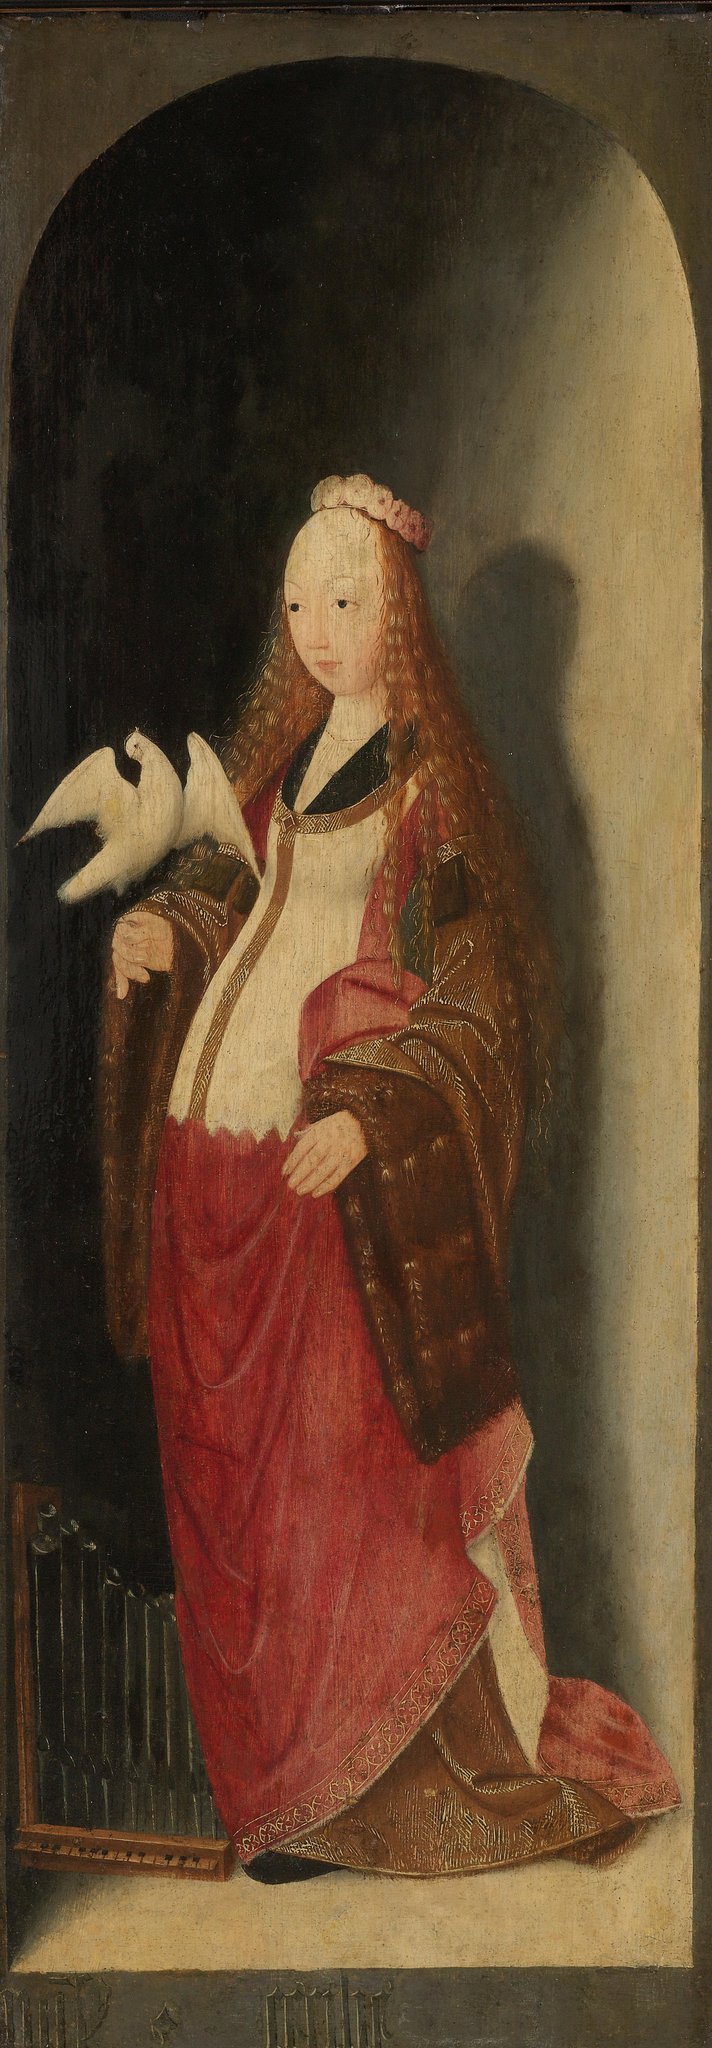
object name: zijpaneel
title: Saint Cecilia, right wing of a triptych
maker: master of the brunswick diptych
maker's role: painter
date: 1490-1500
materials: oil, panel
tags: the virgin martyr cecilia of rome; possible attributes: falcon, musical instruments, organ, wreath of roses and lilies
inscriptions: inscription, inscribed, bottom, on the niche: ‘nup… Cecilie’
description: De buitenzijde van een luik van een drieluik. De heilige Cecilia, staande in een stenen nis, ten voeten, een duif op de rechterhand, aan haar voeten een orgel. Pendant van SK-A-3305.